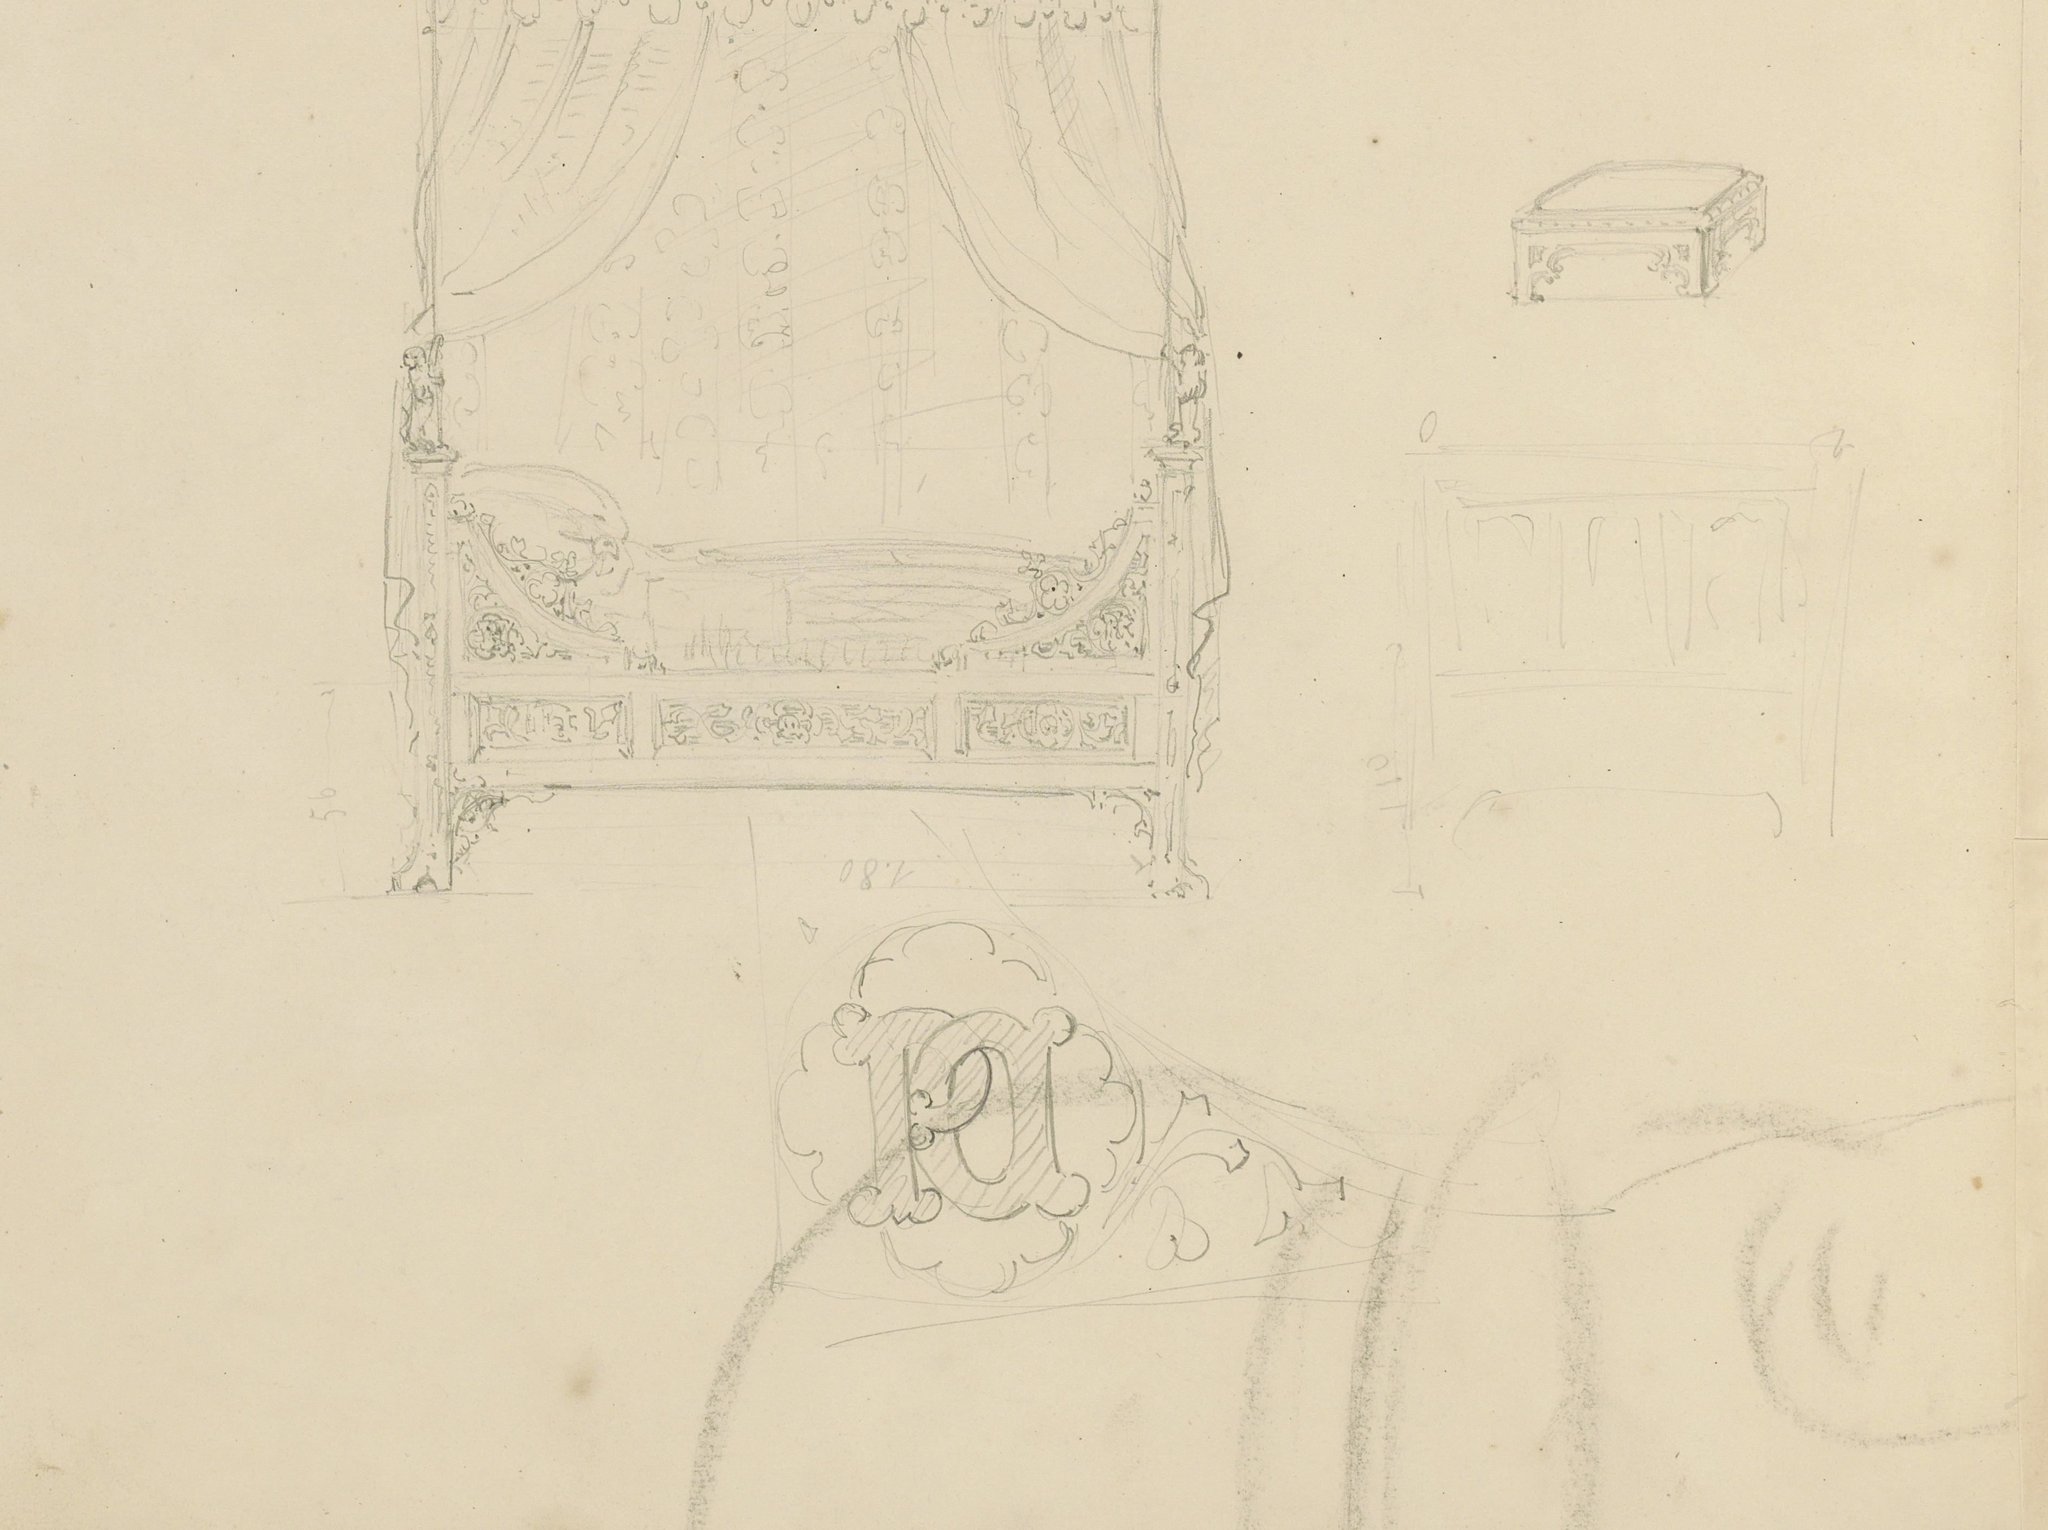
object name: sketchbook leaf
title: Hemelbed, kast en voetenbank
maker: pierre joseph hubert cuypers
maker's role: draughtsman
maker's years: 1827-1921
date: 1850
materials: paper, pencil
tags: footstool, furniture for storage, bed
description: Tevens een studie van een monogram. Blad 32 verso uit een schetsboek met 37 bladen.